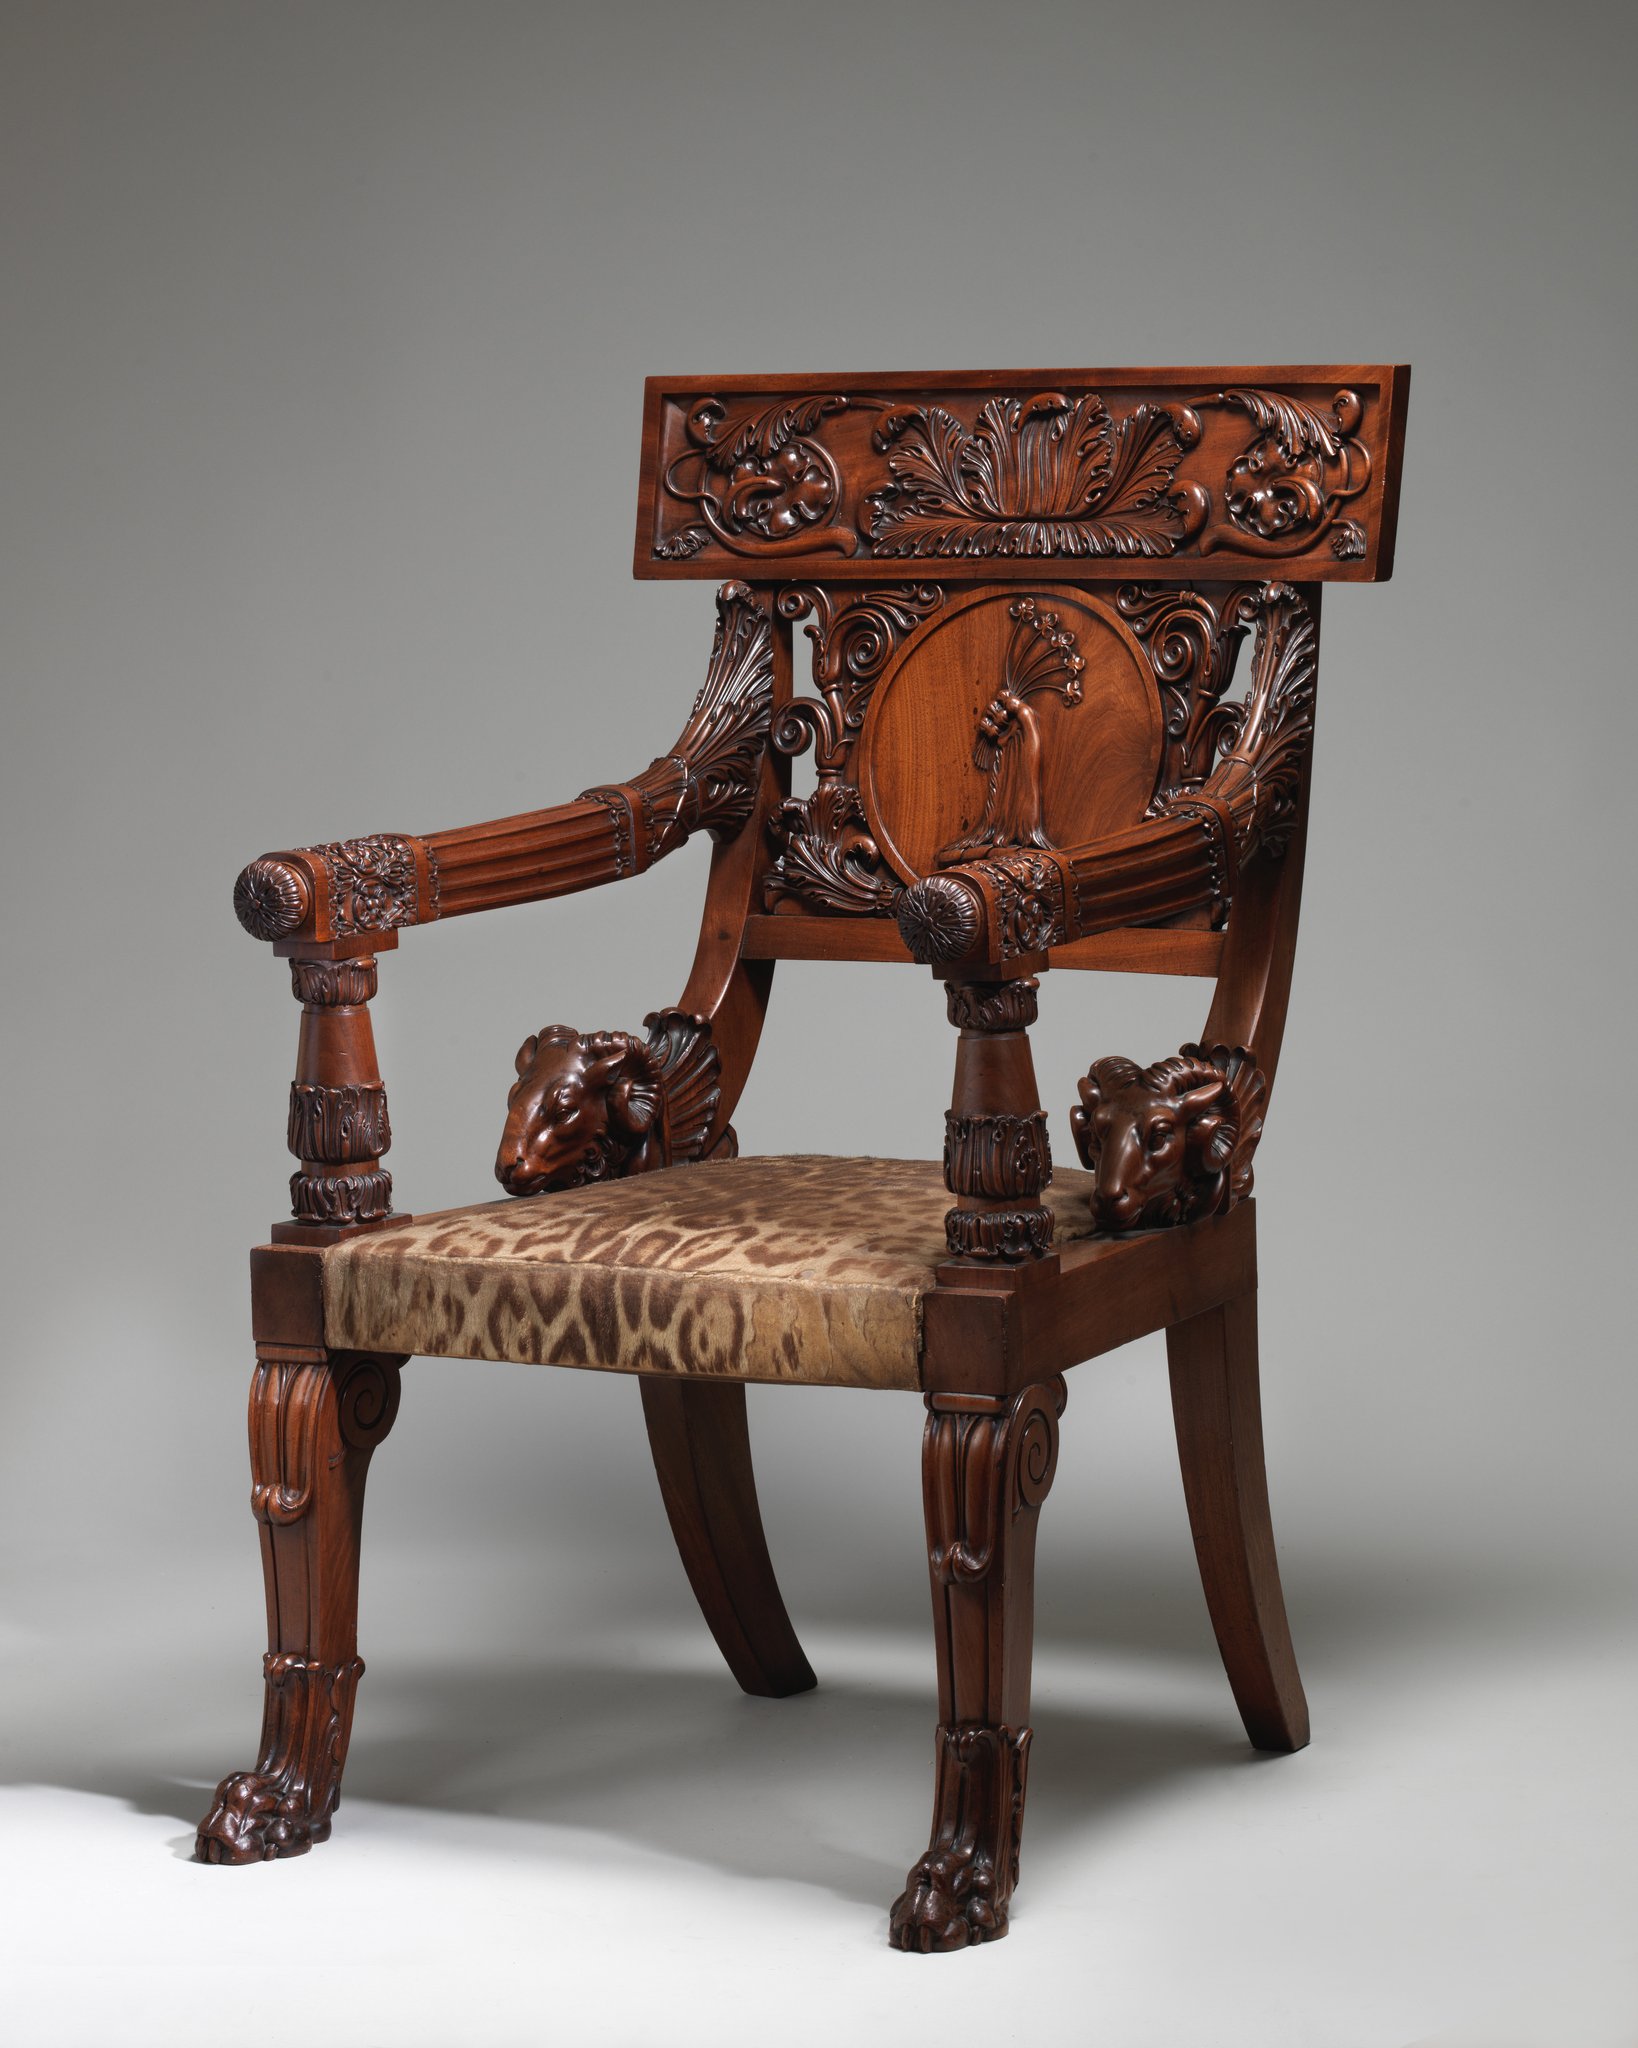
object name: armchair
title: Armchair (part of a set)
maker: charles dixwell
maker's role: maker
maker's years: 1775-1875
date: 1820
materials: wood, skin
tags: rams